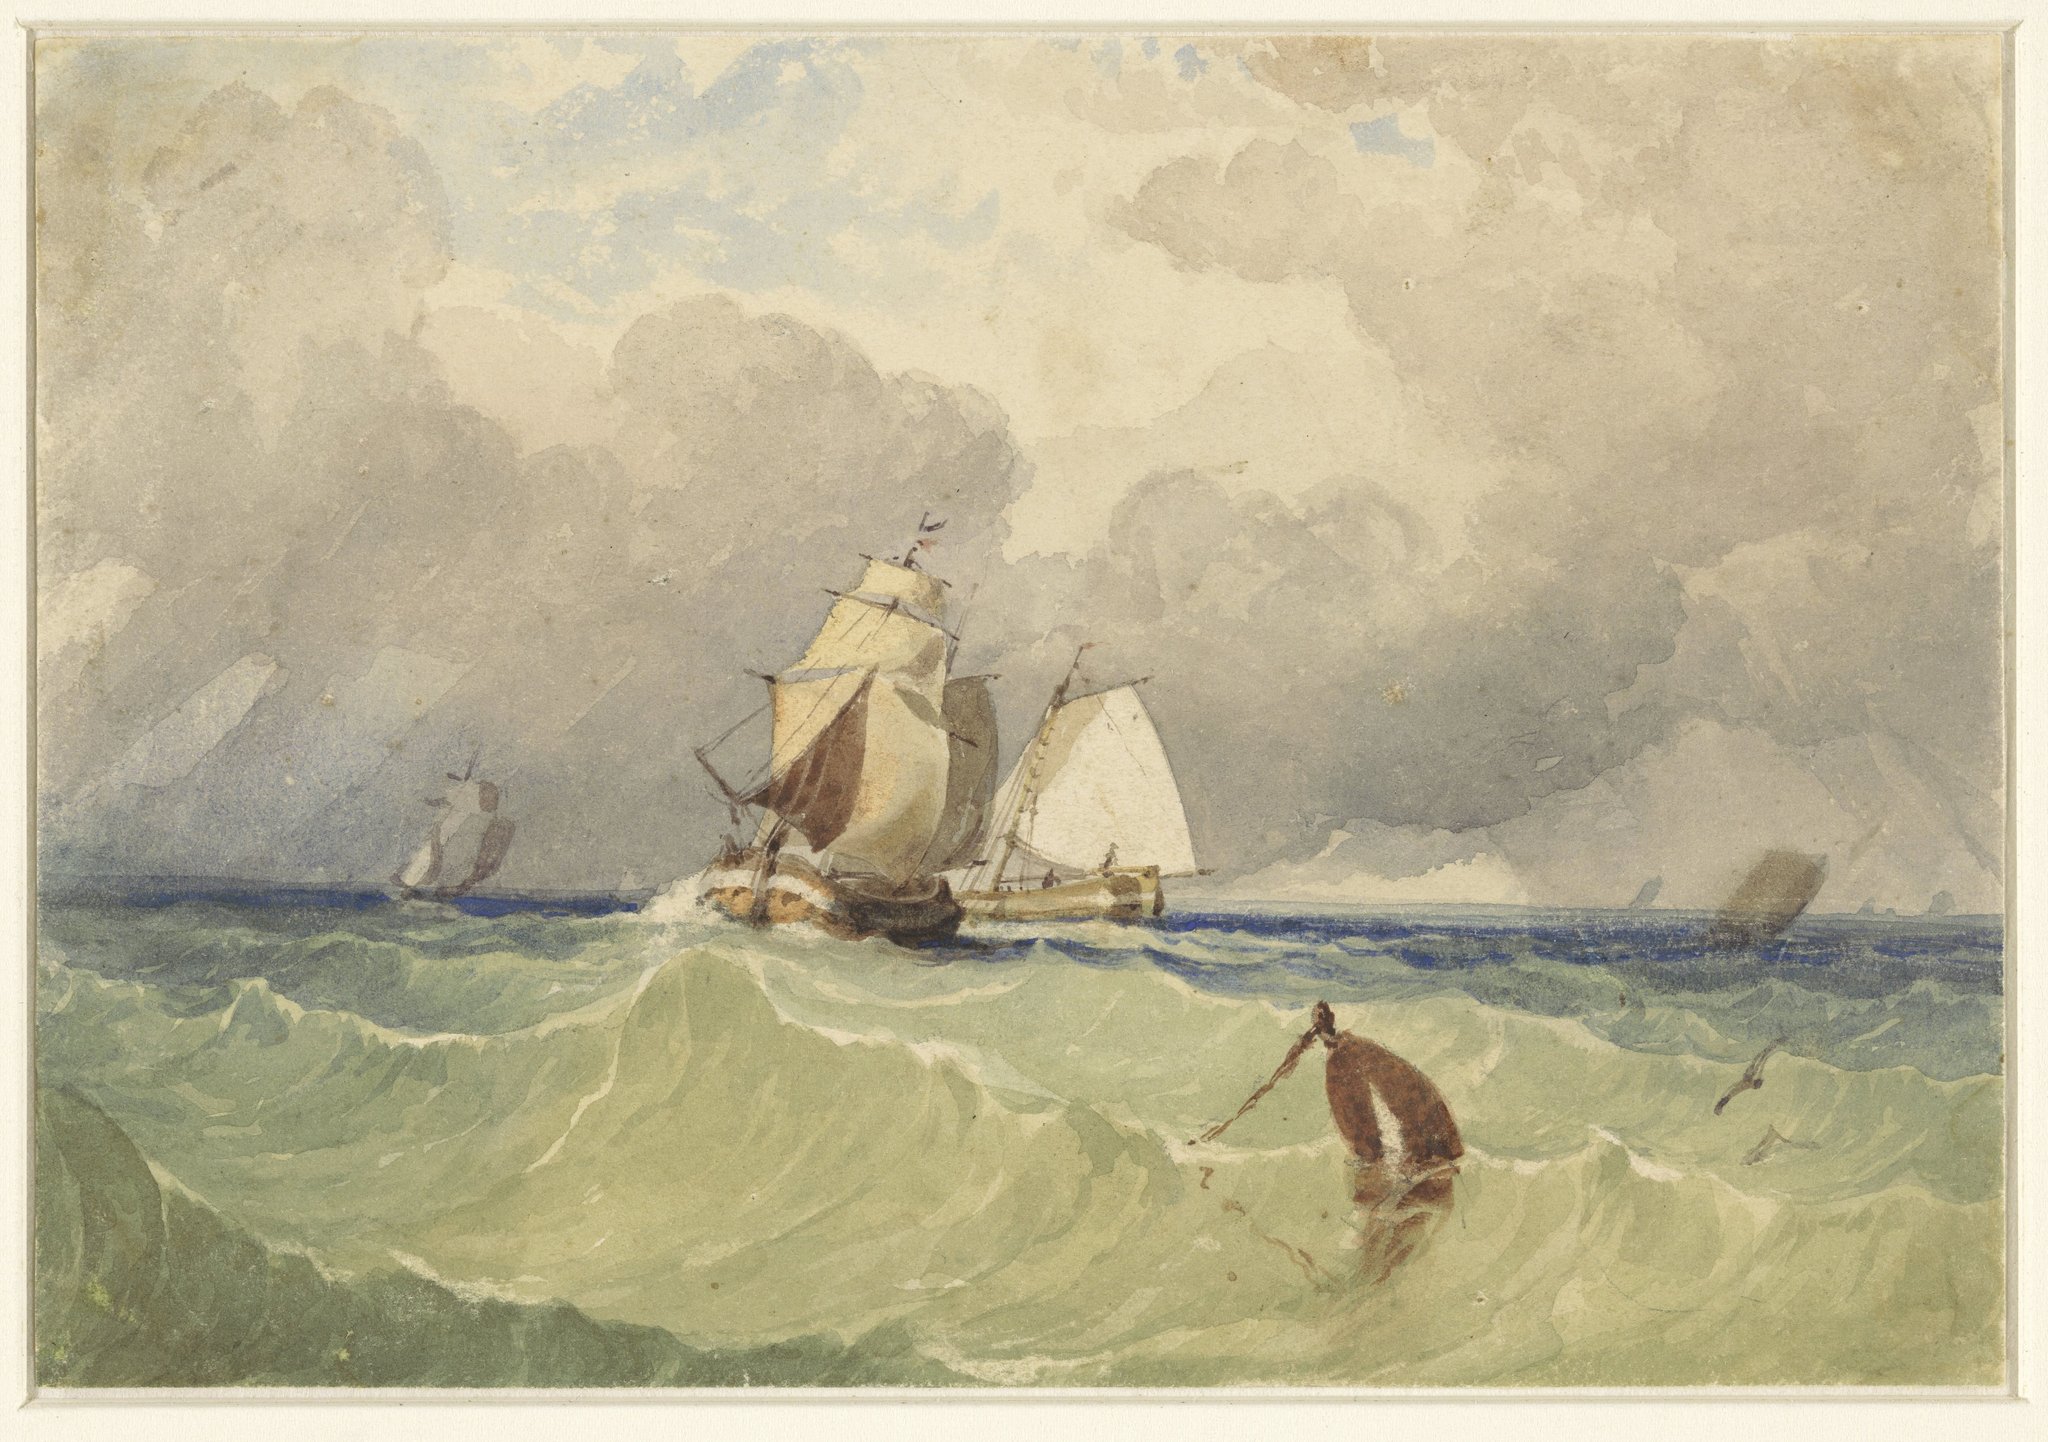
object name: drawing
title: Driemasters en tjalk zeilend in volle zee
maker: thomas sewell robins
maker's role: draughtsman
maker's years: 1814-1880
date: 1830-1880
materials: paper, watercolor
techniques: brush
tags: sailing-ship, sailing-boat, sea (seascape) (+ landscape with figures, staffage)